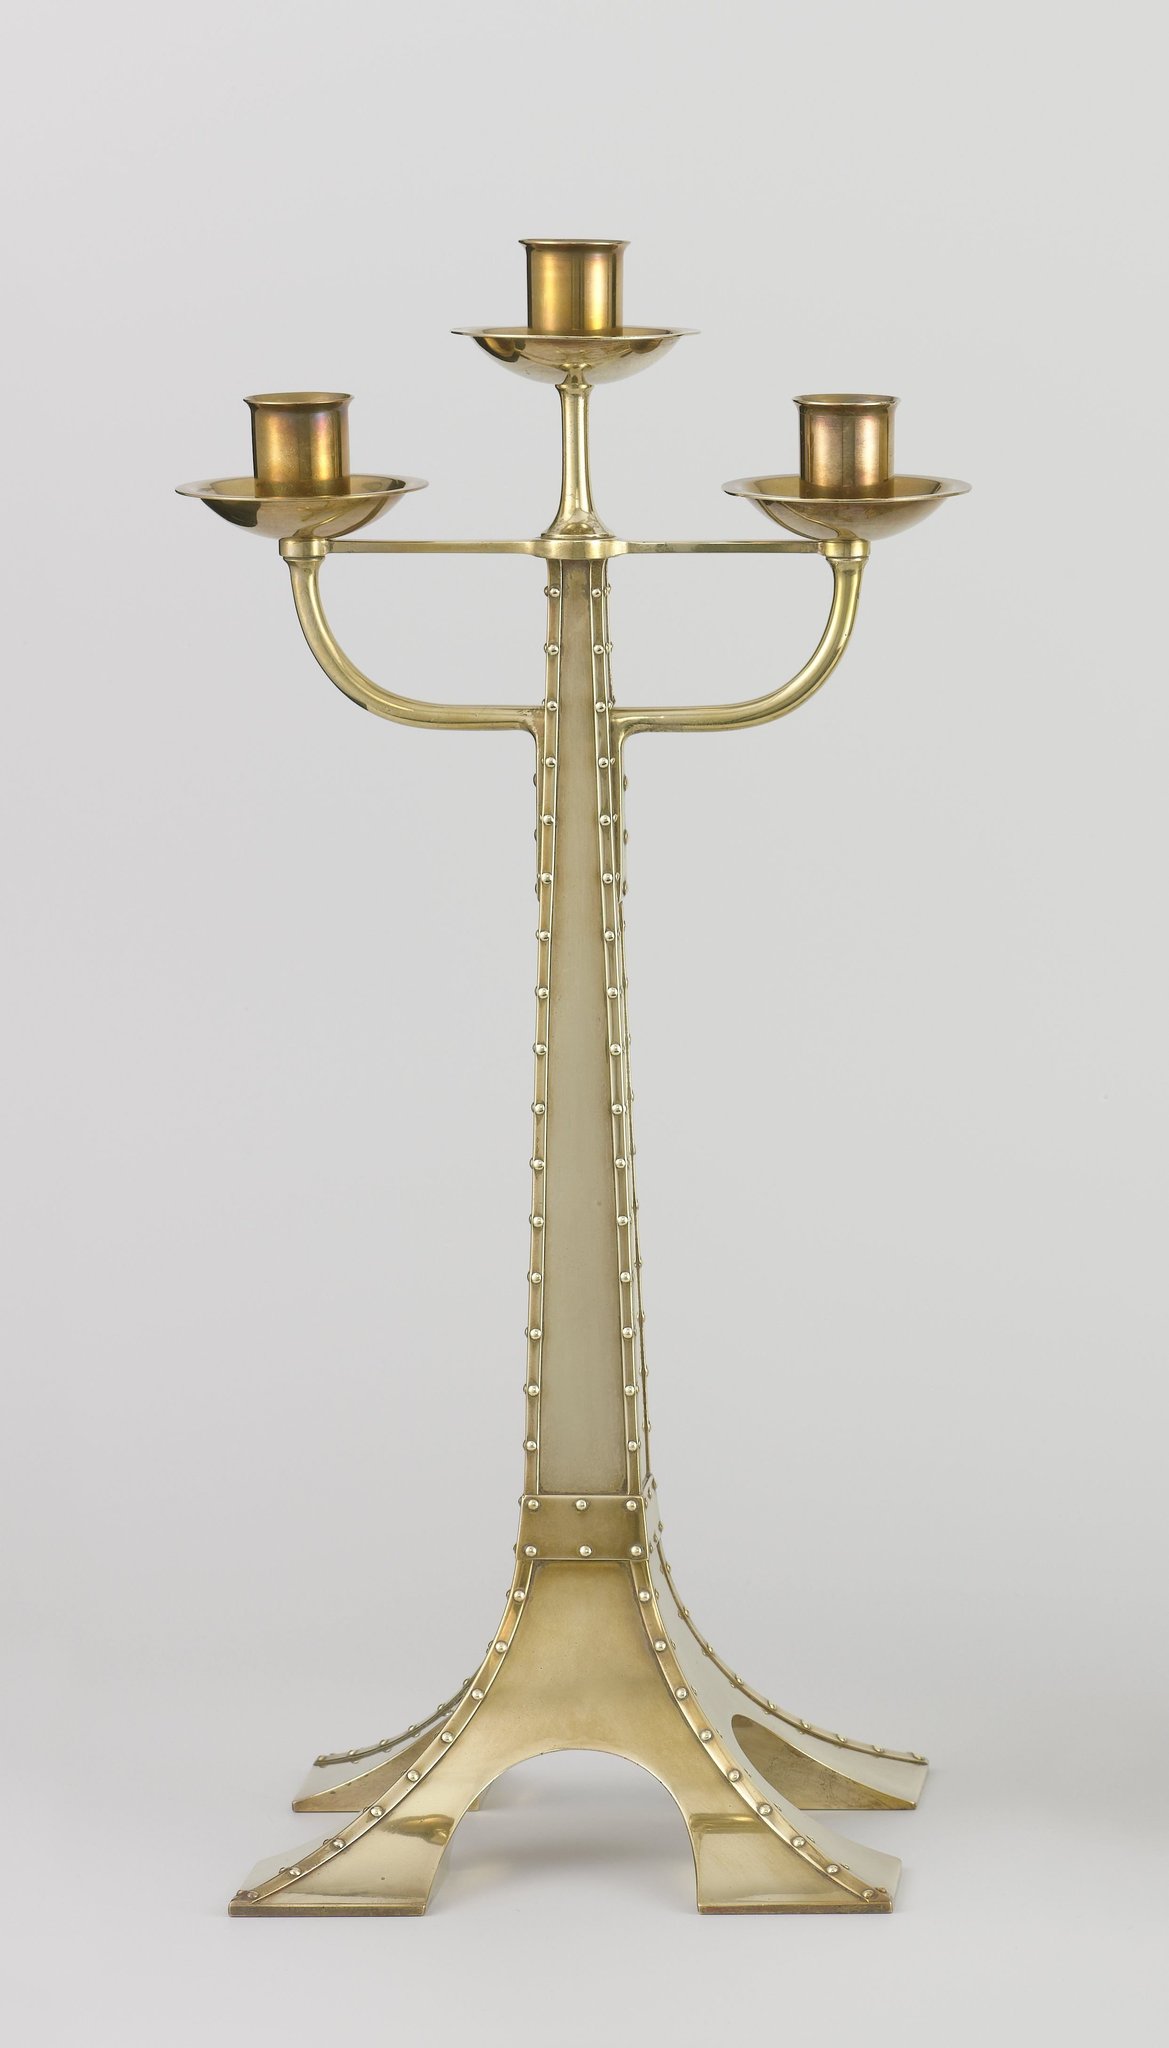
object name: candelabrum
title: Mantle clock with two candelabra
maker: hendrik petrus berlage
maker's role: draughtsman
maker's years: 1856-1934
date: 1900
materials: brass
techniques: riveted, soldering, striking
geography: amsterdam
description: The design of this ensemble is sober and rational, the distinctive style of the influential Dutch architect Berlage. Connecting elements, such as rivets, are clearly visible and accentuate both the construction and the form. The broad, splayed feet resemble the base of the Eiffel Tower, completed in 1889, which was the shining example of engineering of its time.